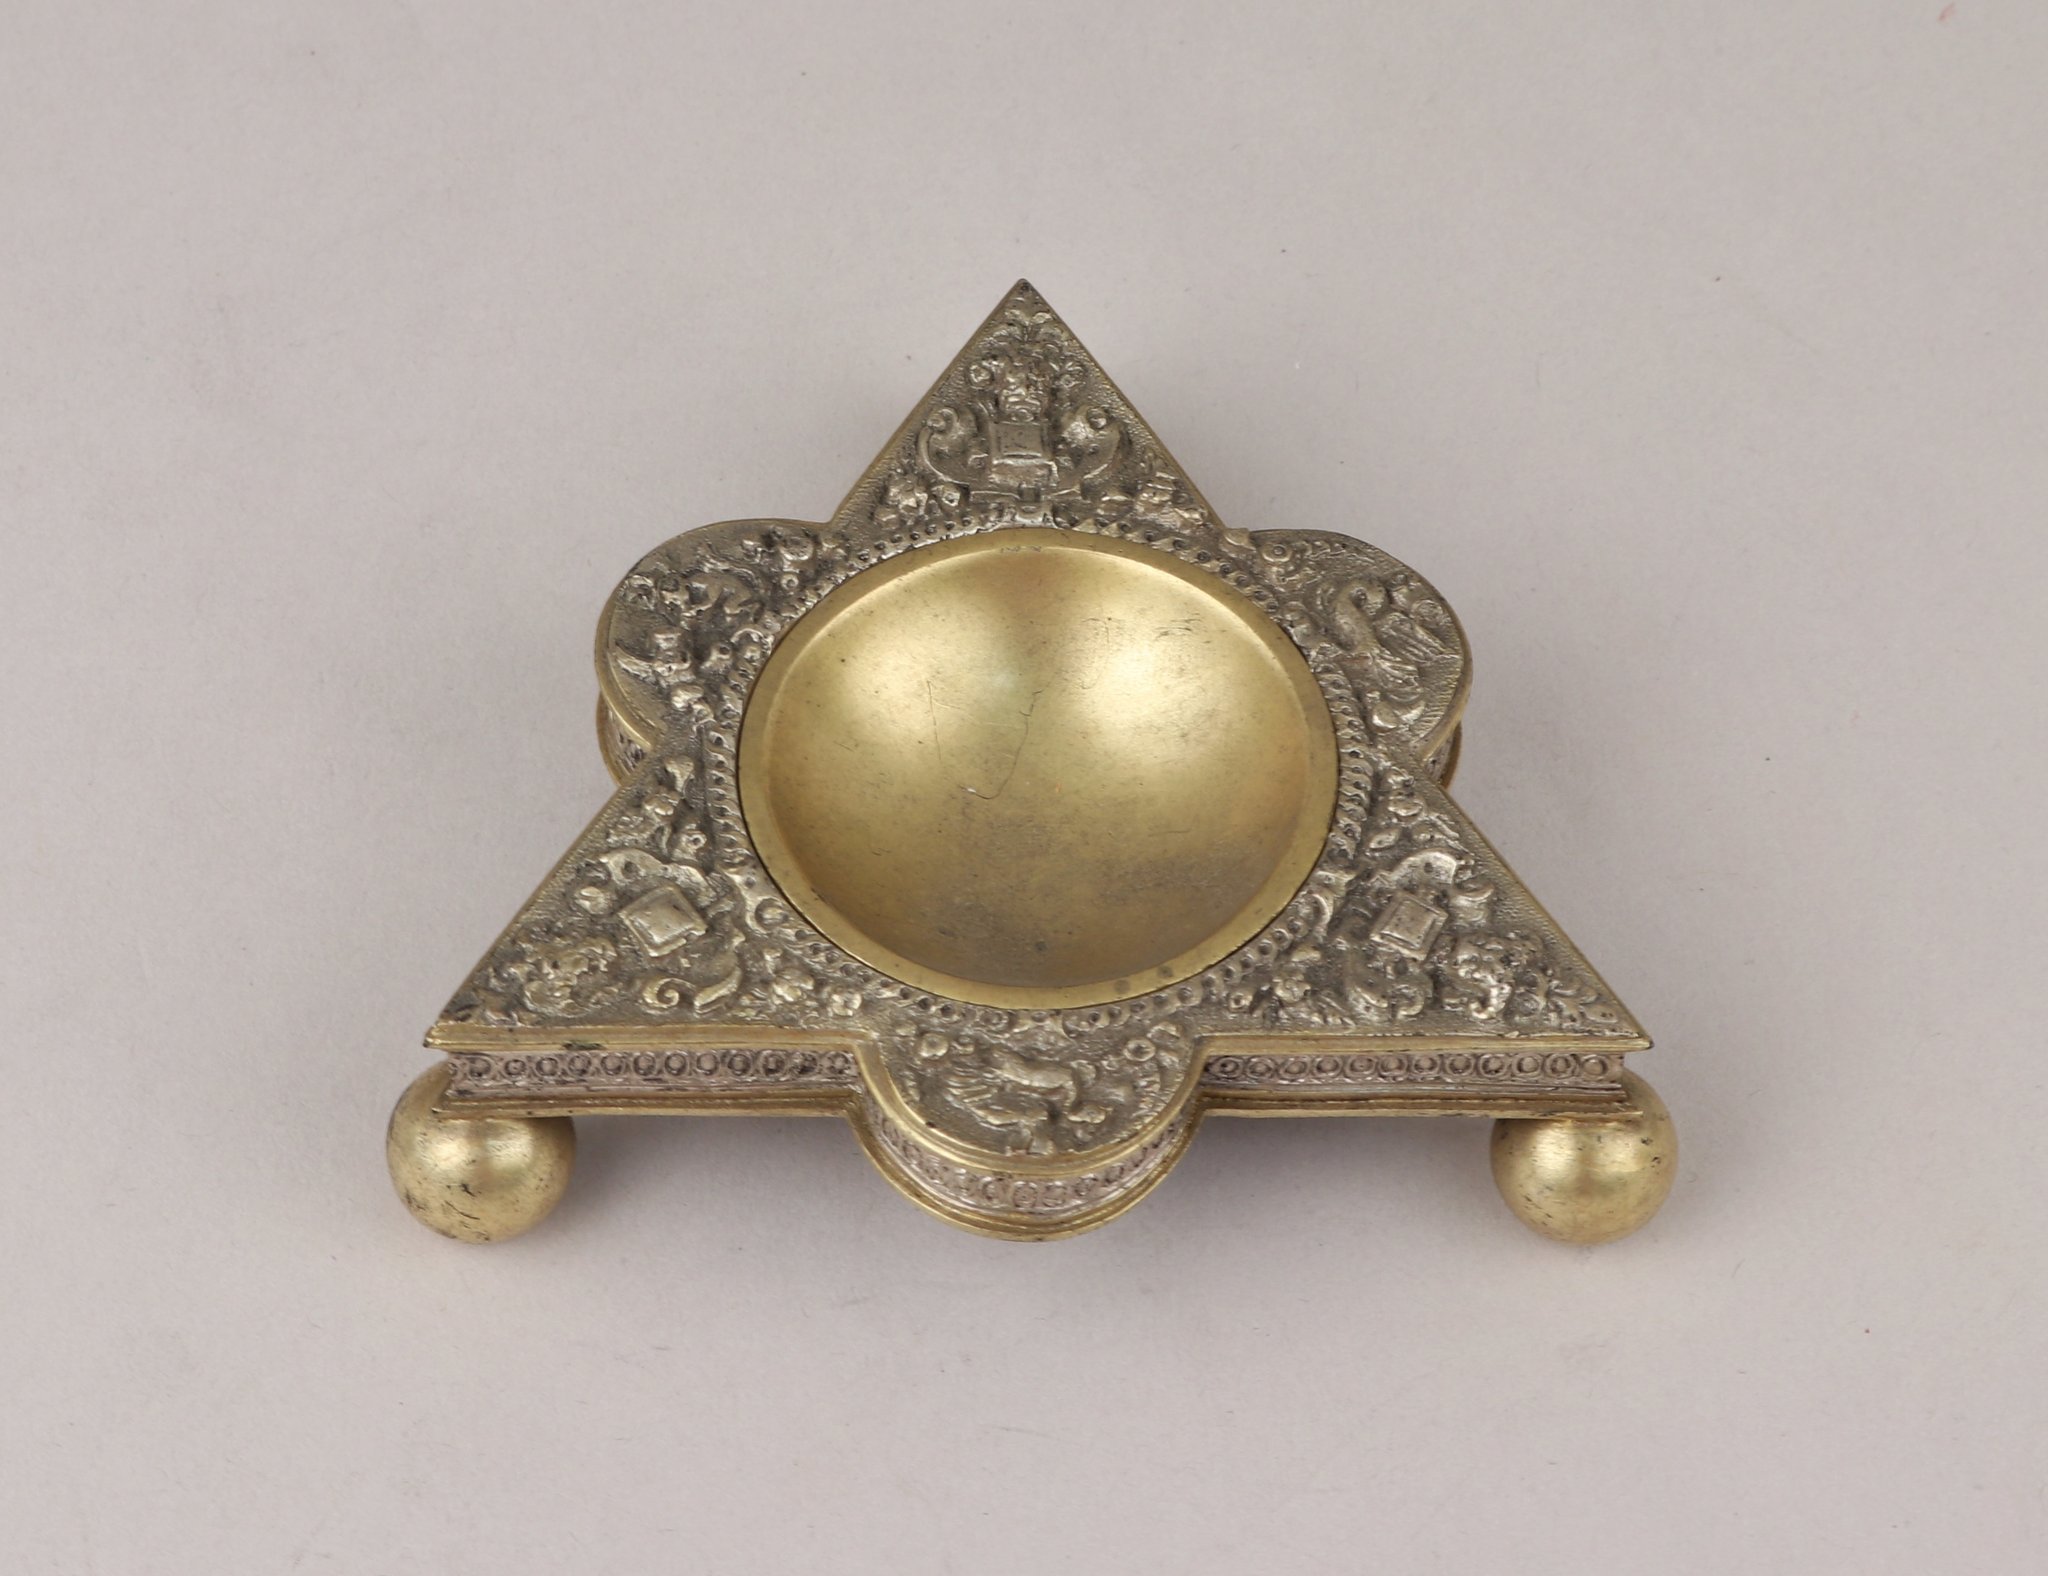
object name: saltcellar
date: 1801-1900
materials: metal, silver